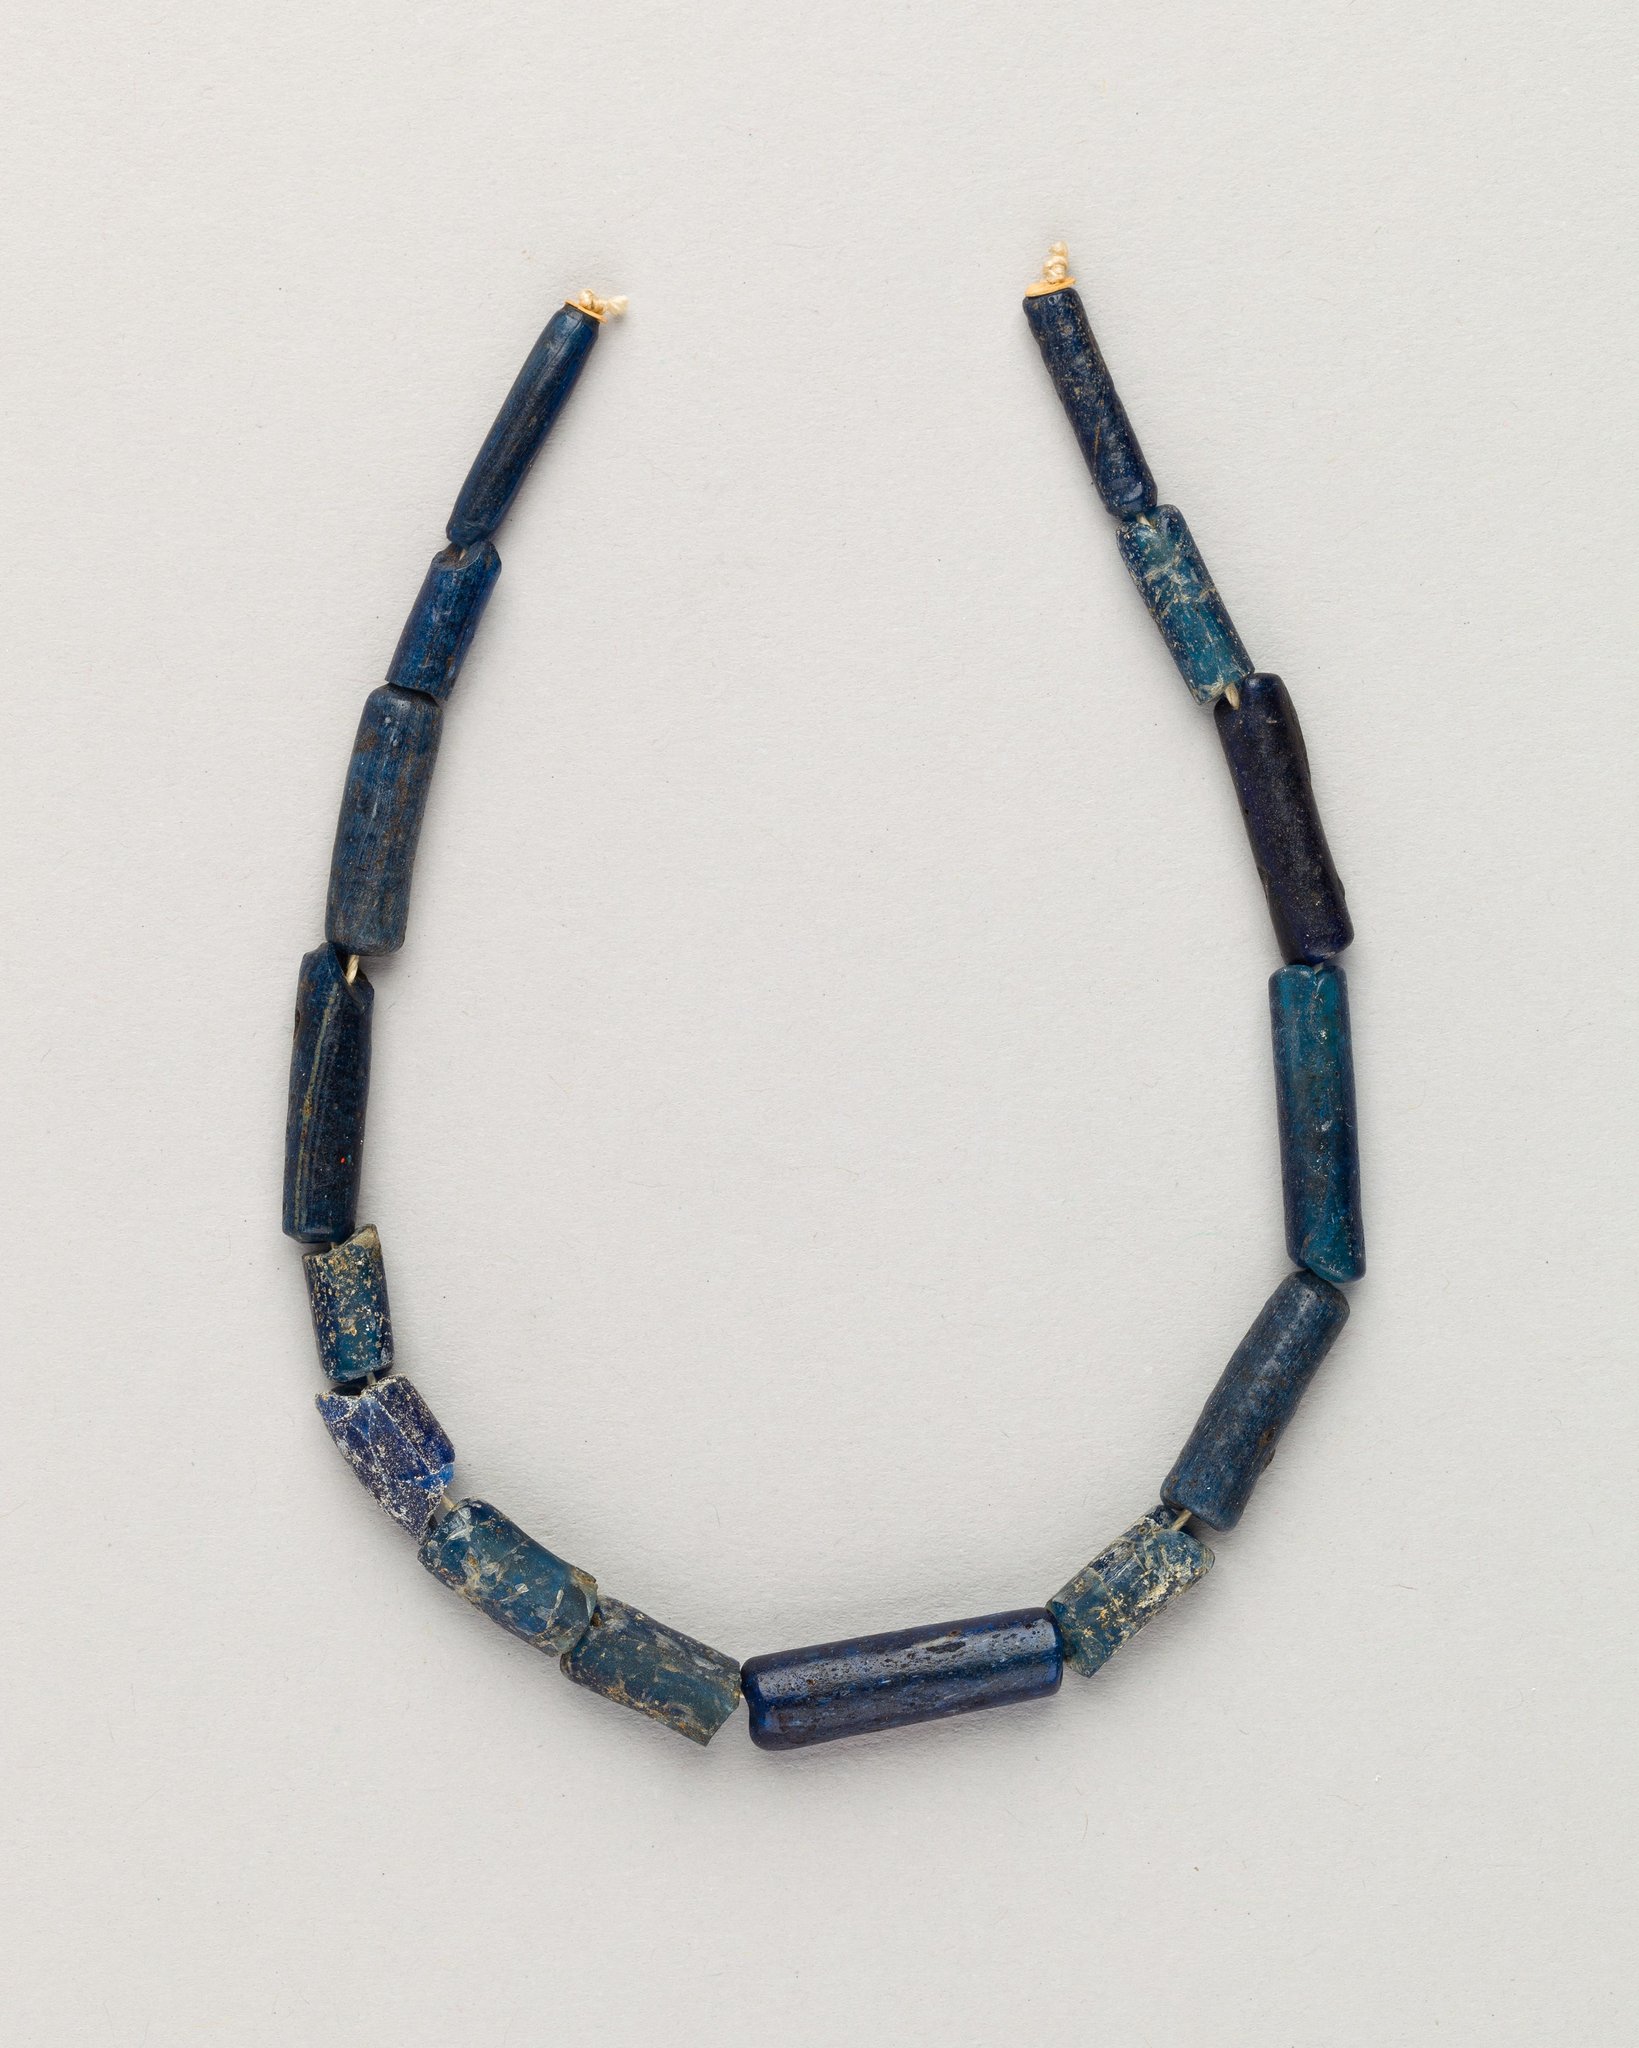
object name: bead, string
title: String of 15 bugle beads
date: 1-366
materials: glass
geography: egypt